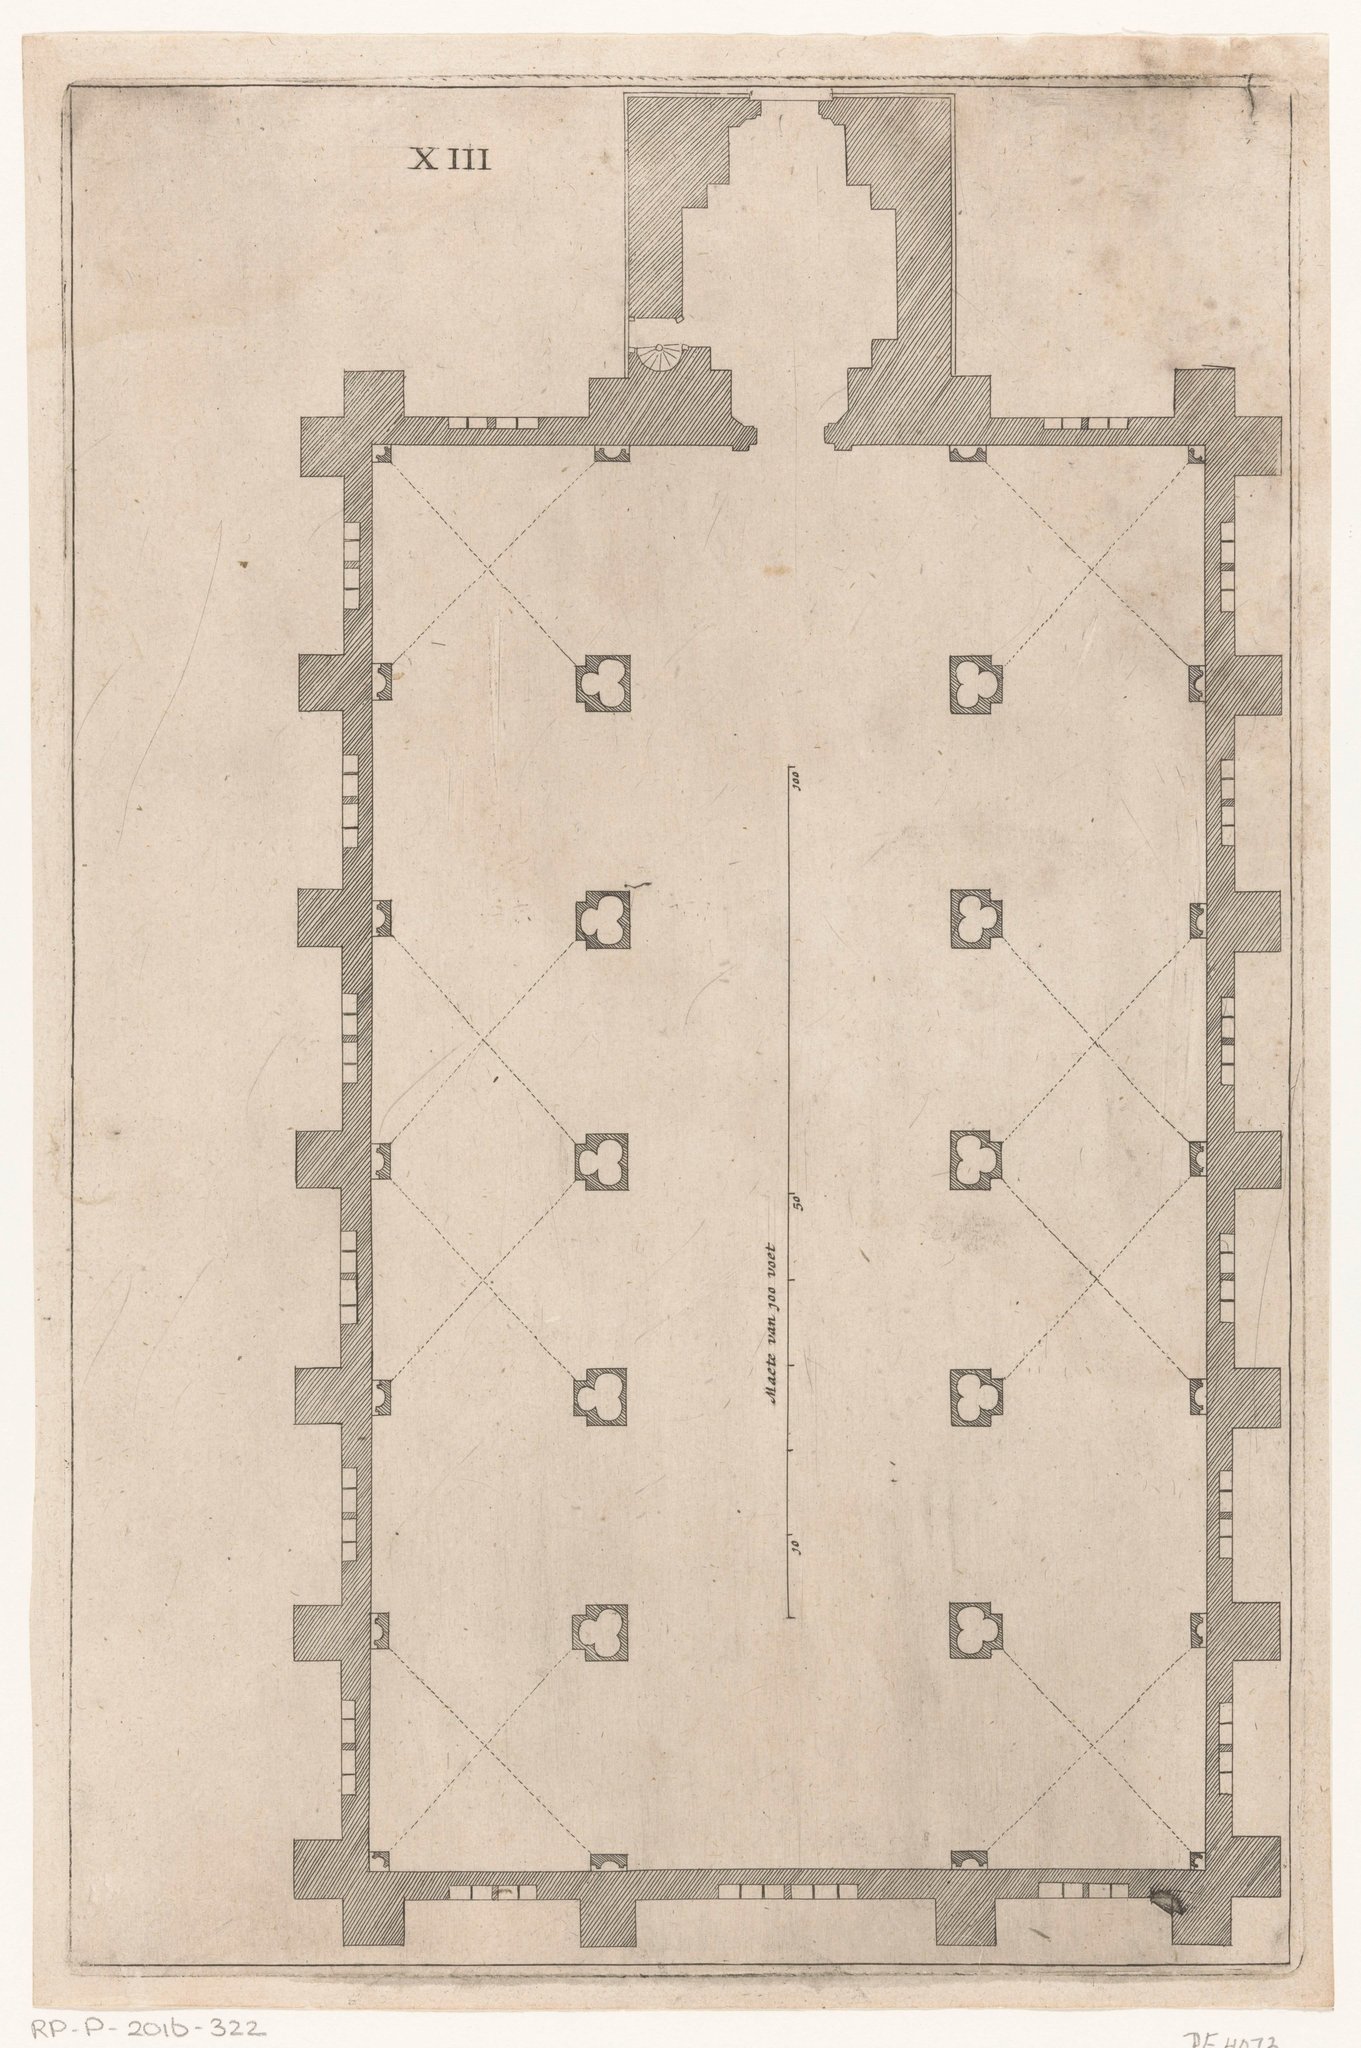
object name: ornament print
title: Plattegrond van de Westerkerk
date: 1631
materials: paper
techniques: engraving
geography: amsterdam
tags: church (exterior), plan ~ architecture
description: Prent uit: Keyser, Hendrick de. Architectura moderna ofte bouwinge van onsen tyt (...) alle gedaen by (...) Amsterdam: Danckerts, Cornelis, 1631.